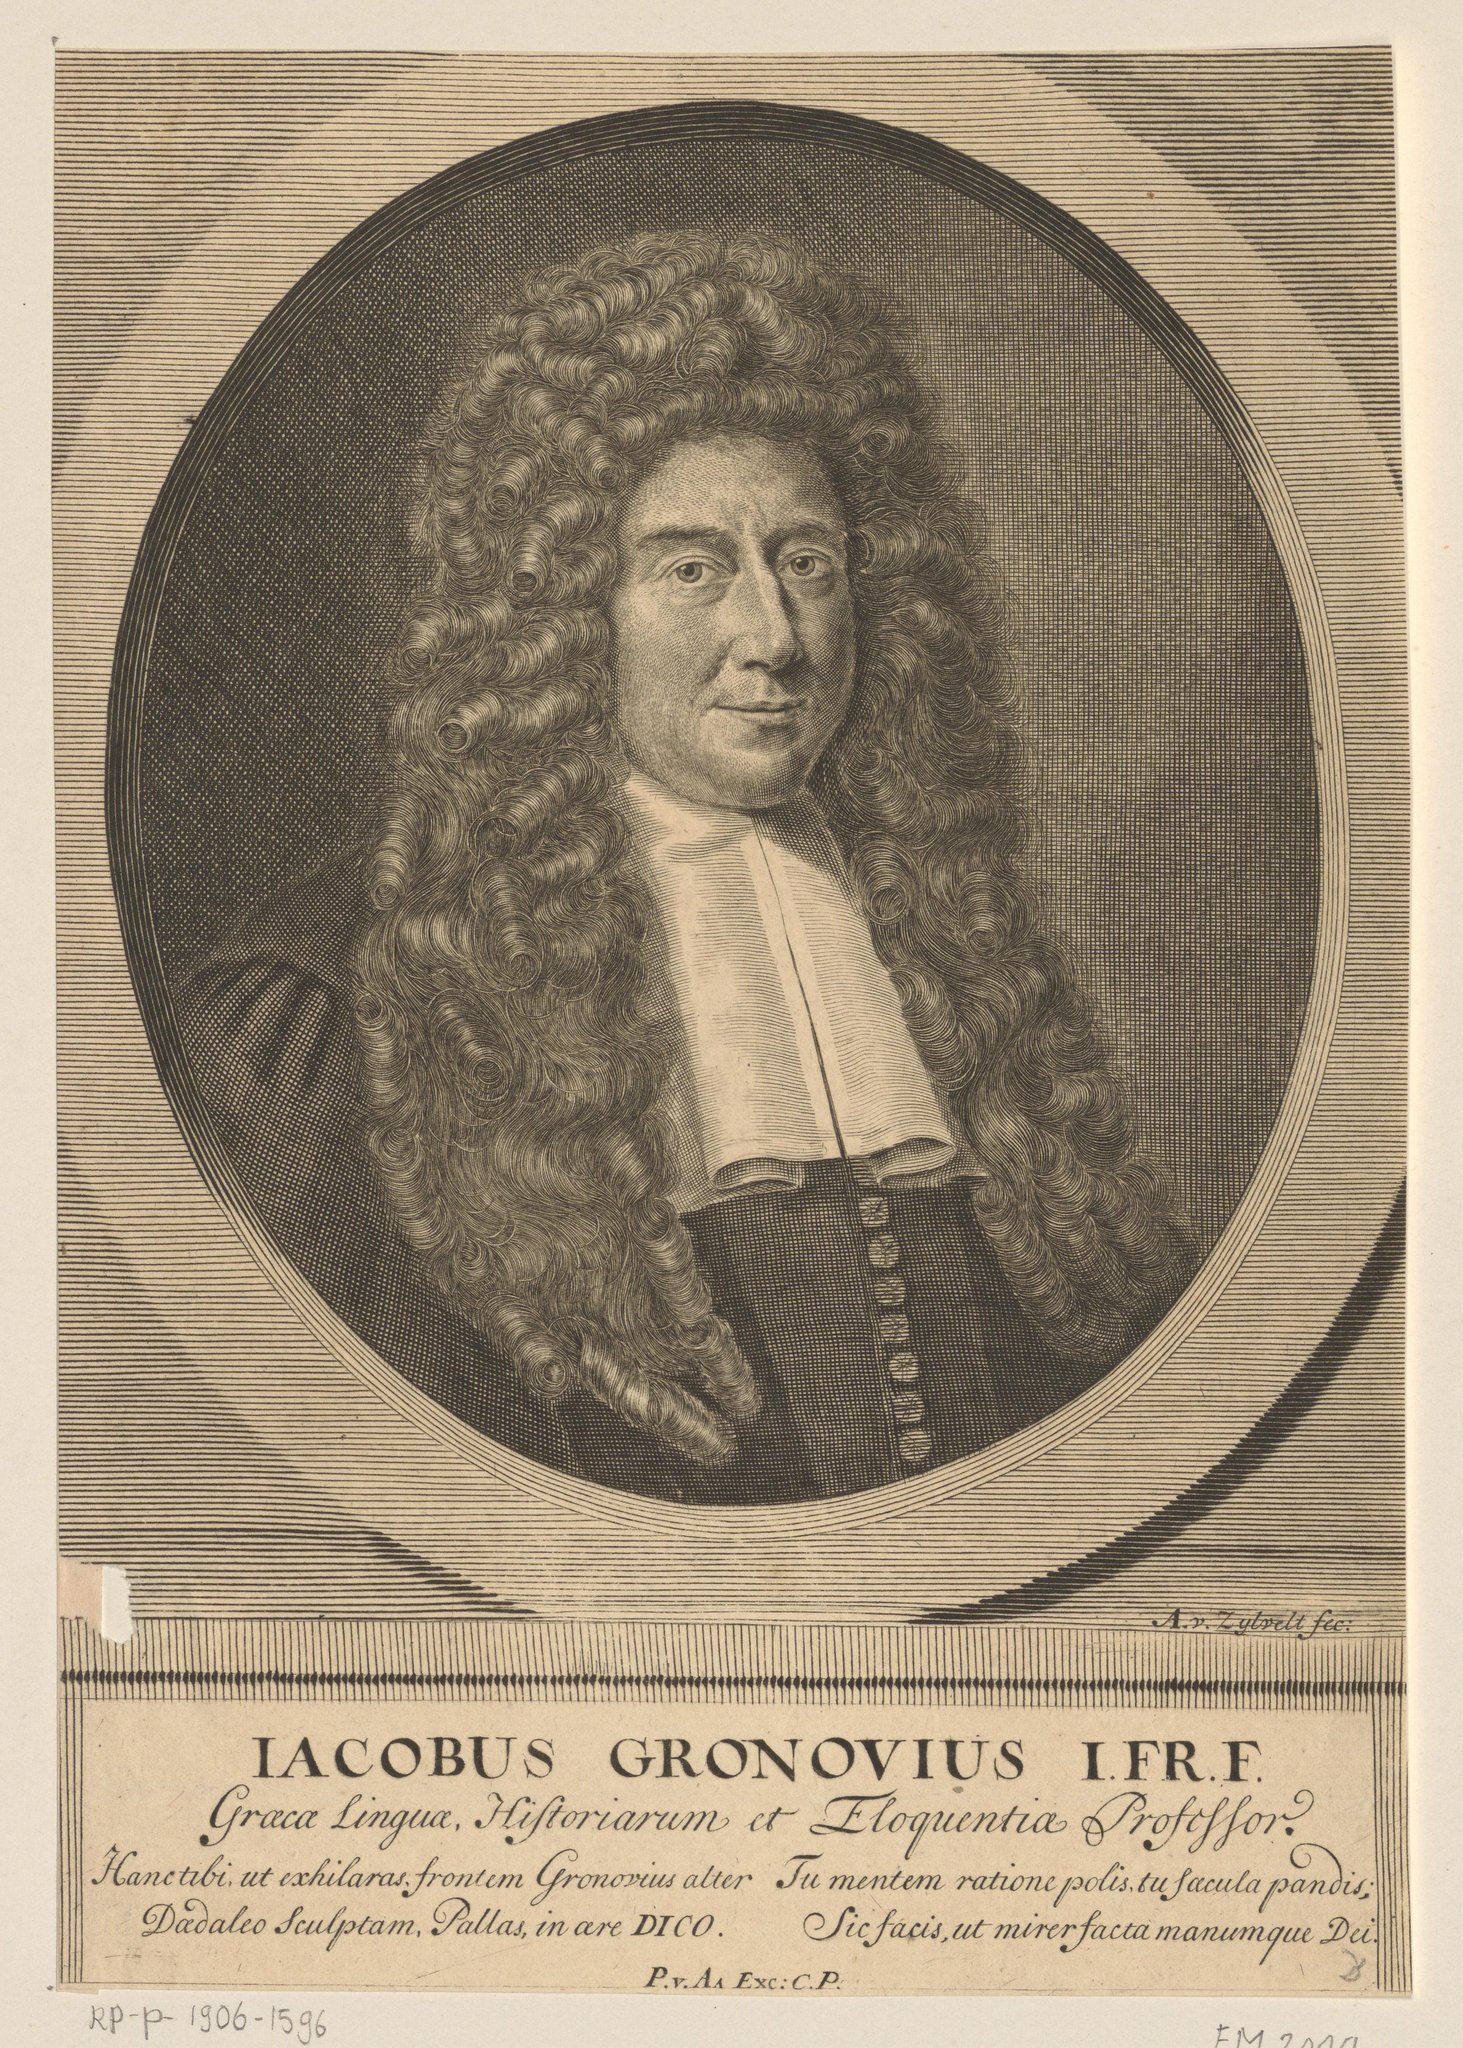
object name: print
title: Portret van Jacob Gronovius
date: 1693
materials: paper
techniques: engraving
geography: leiden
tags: leiden, jacob gronovius, historical persons, professor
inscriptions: collector's mark: Lugt 2228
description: Prent uit: Marcellinus, Ammianus. Rerum gestarum qui de XXXI supersunt, libri XVIII. [Vertaald en geredigeerd door] Jacobus Gronovius. Leiden: Pieter van der Aa (I), 1693.